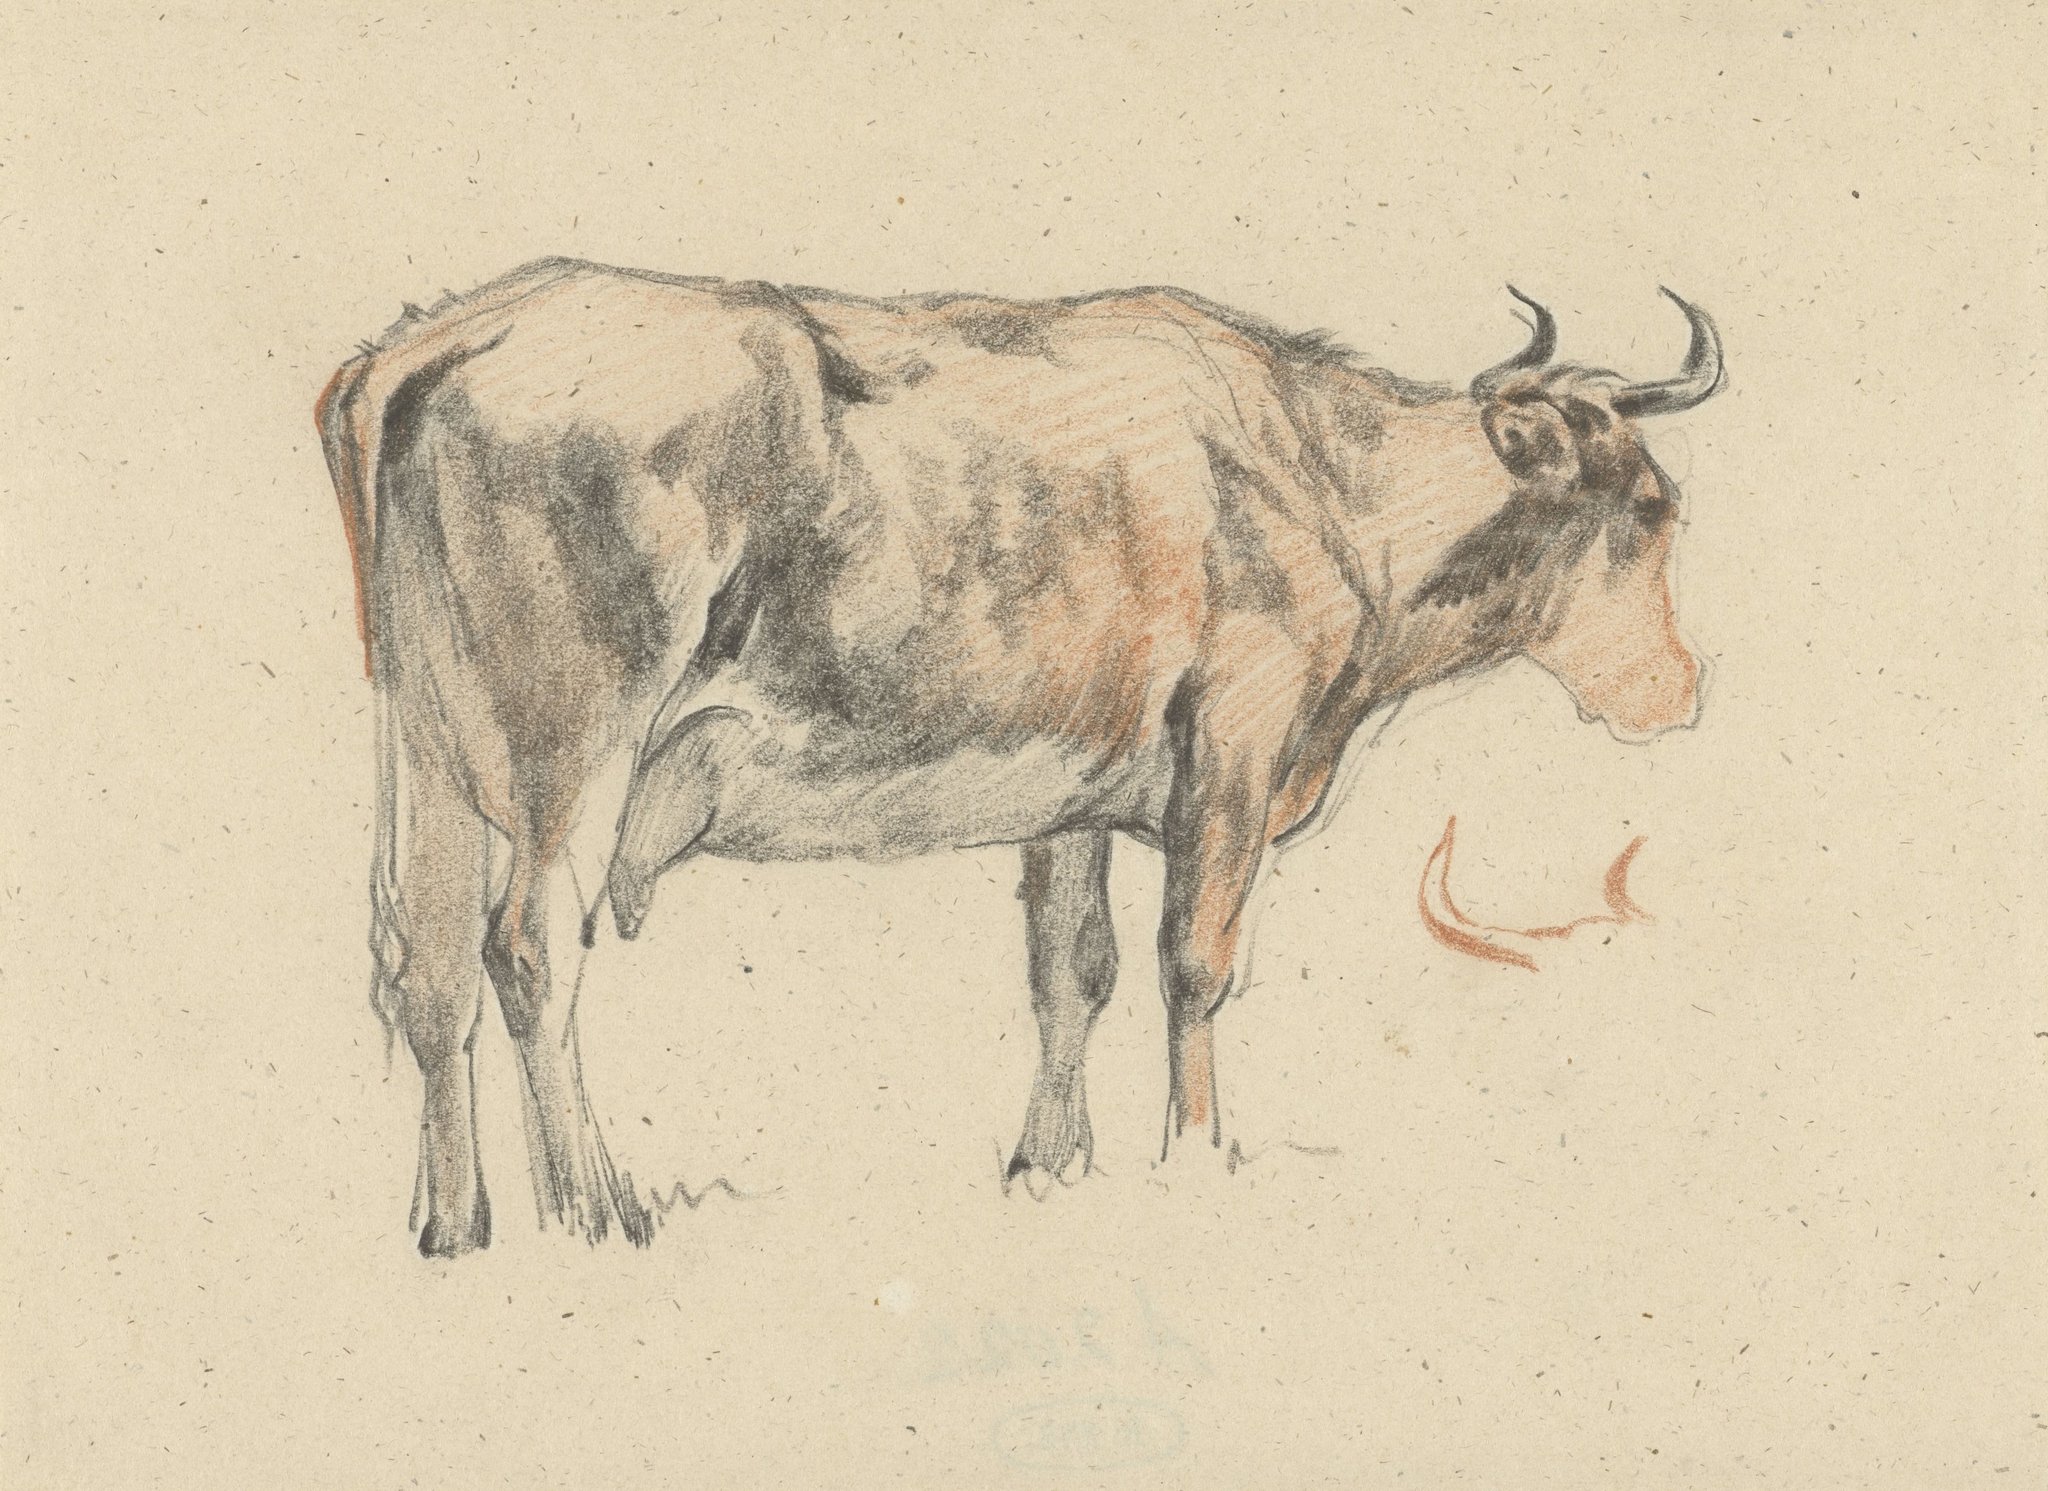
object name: drawing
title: Staande koe, naar rechts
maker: guillaume anne van der brugghen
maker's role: draughtsman, print maker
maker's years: 1812-1891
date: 1821-1889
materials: chalk, paper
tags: cow